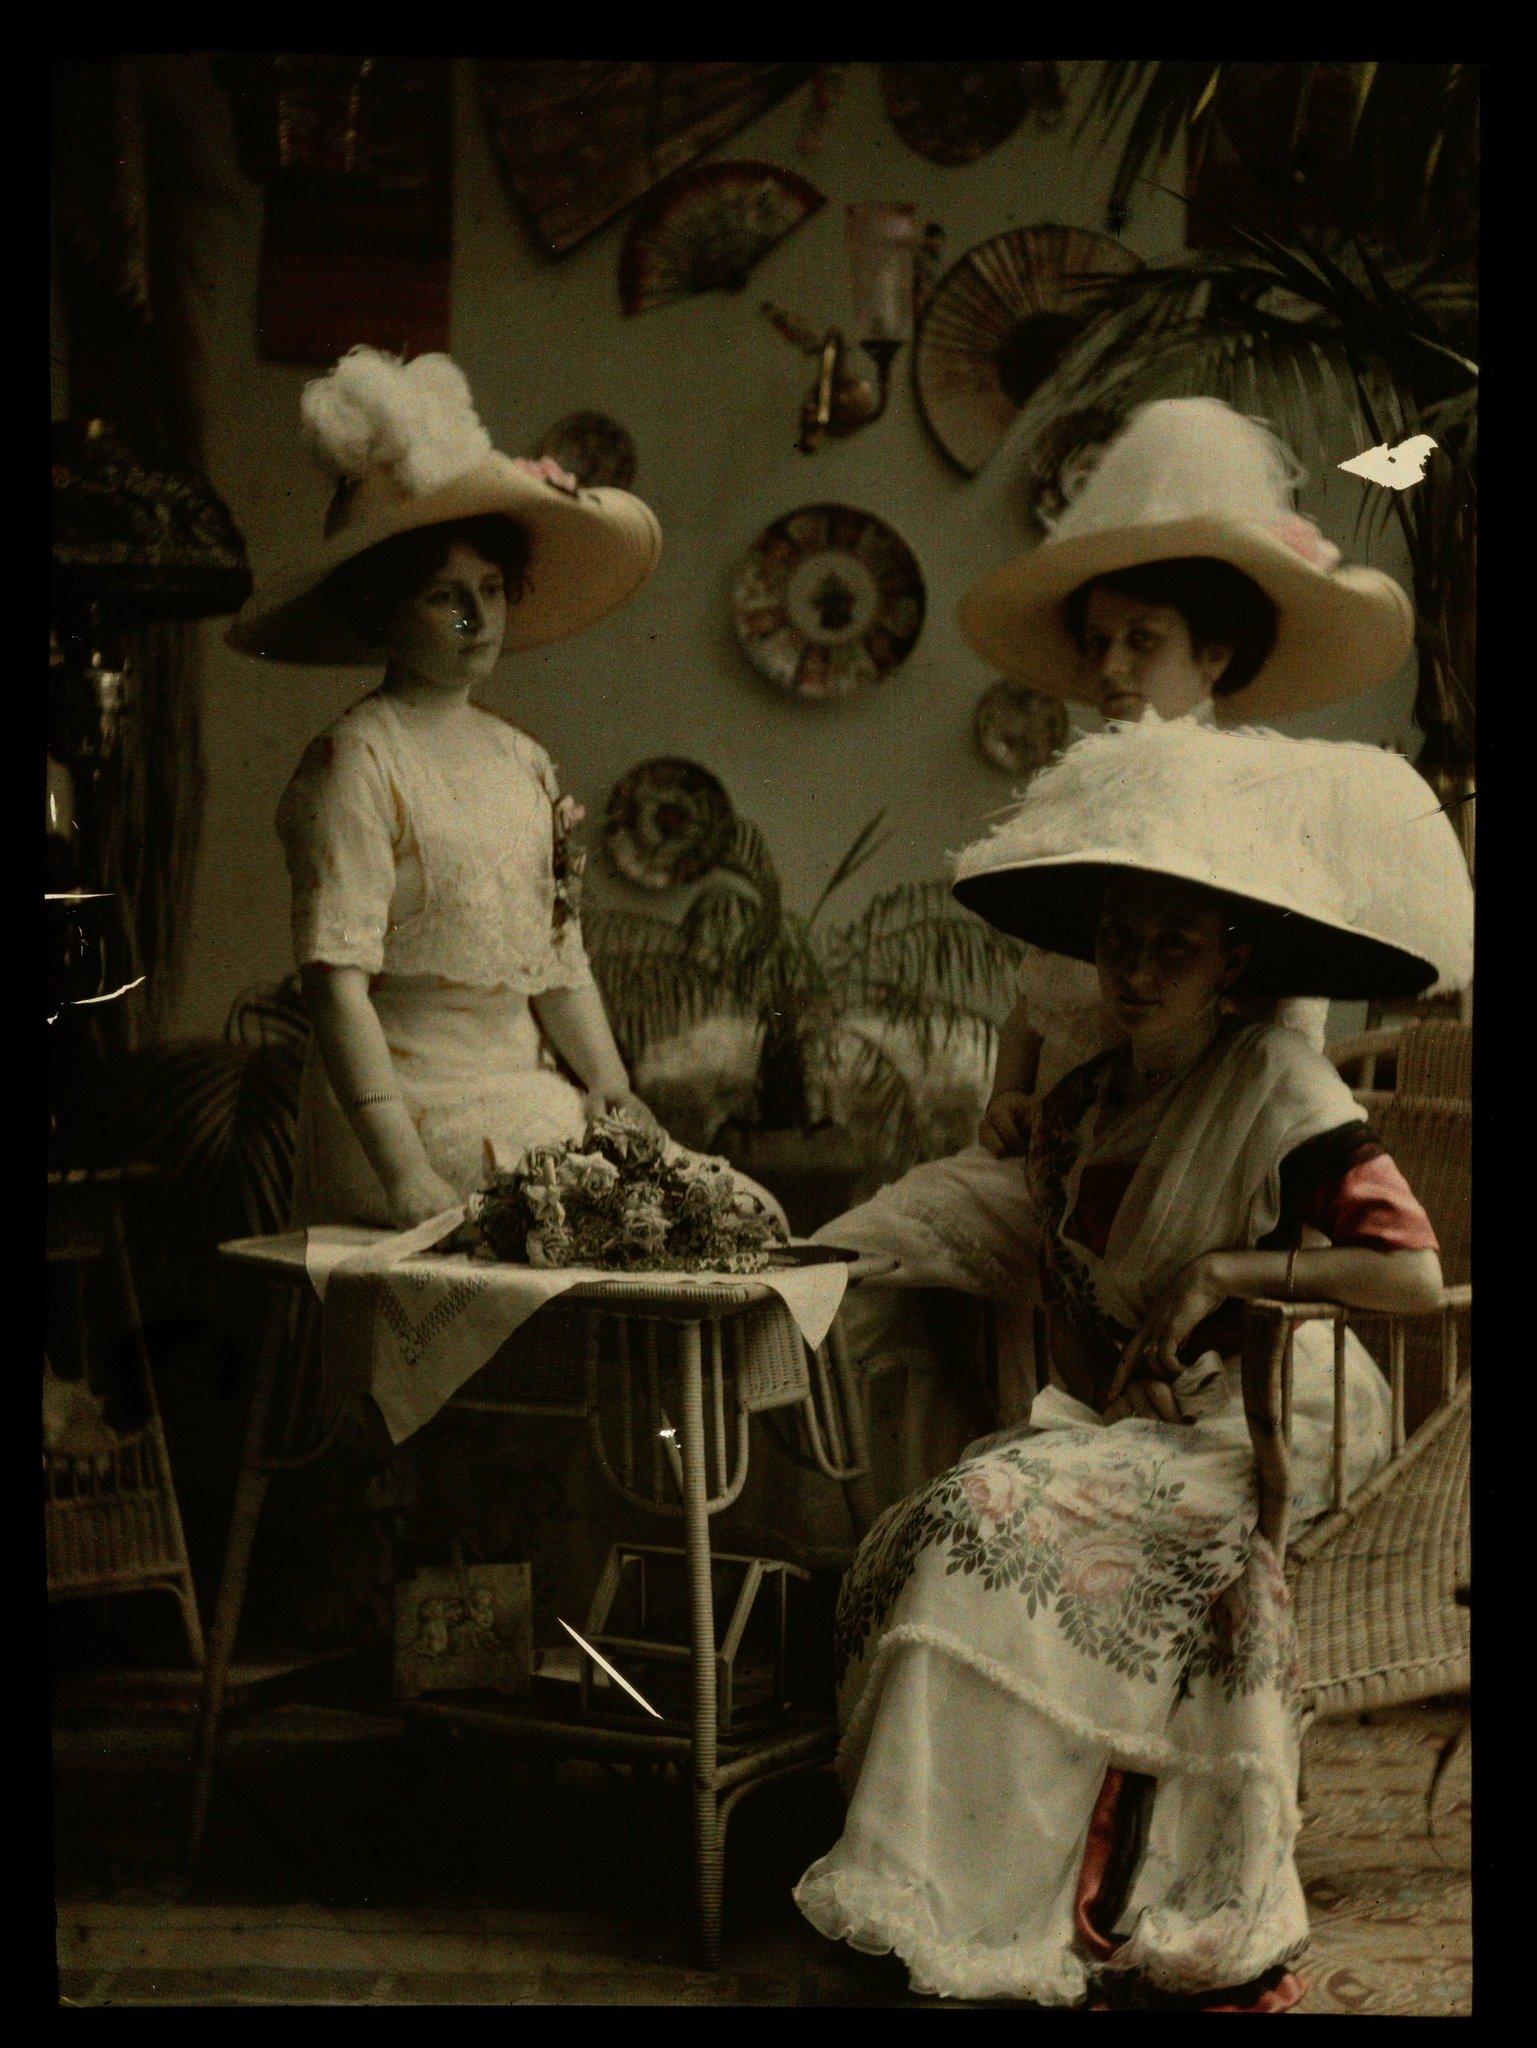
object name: photograph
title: Drie vrouwen met hoeden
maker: johannes hendrikus antonius maria lutz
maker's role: fotograaf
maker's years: -1916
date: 1907-1916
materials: glass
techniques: autochrome process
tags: head-gear: hat